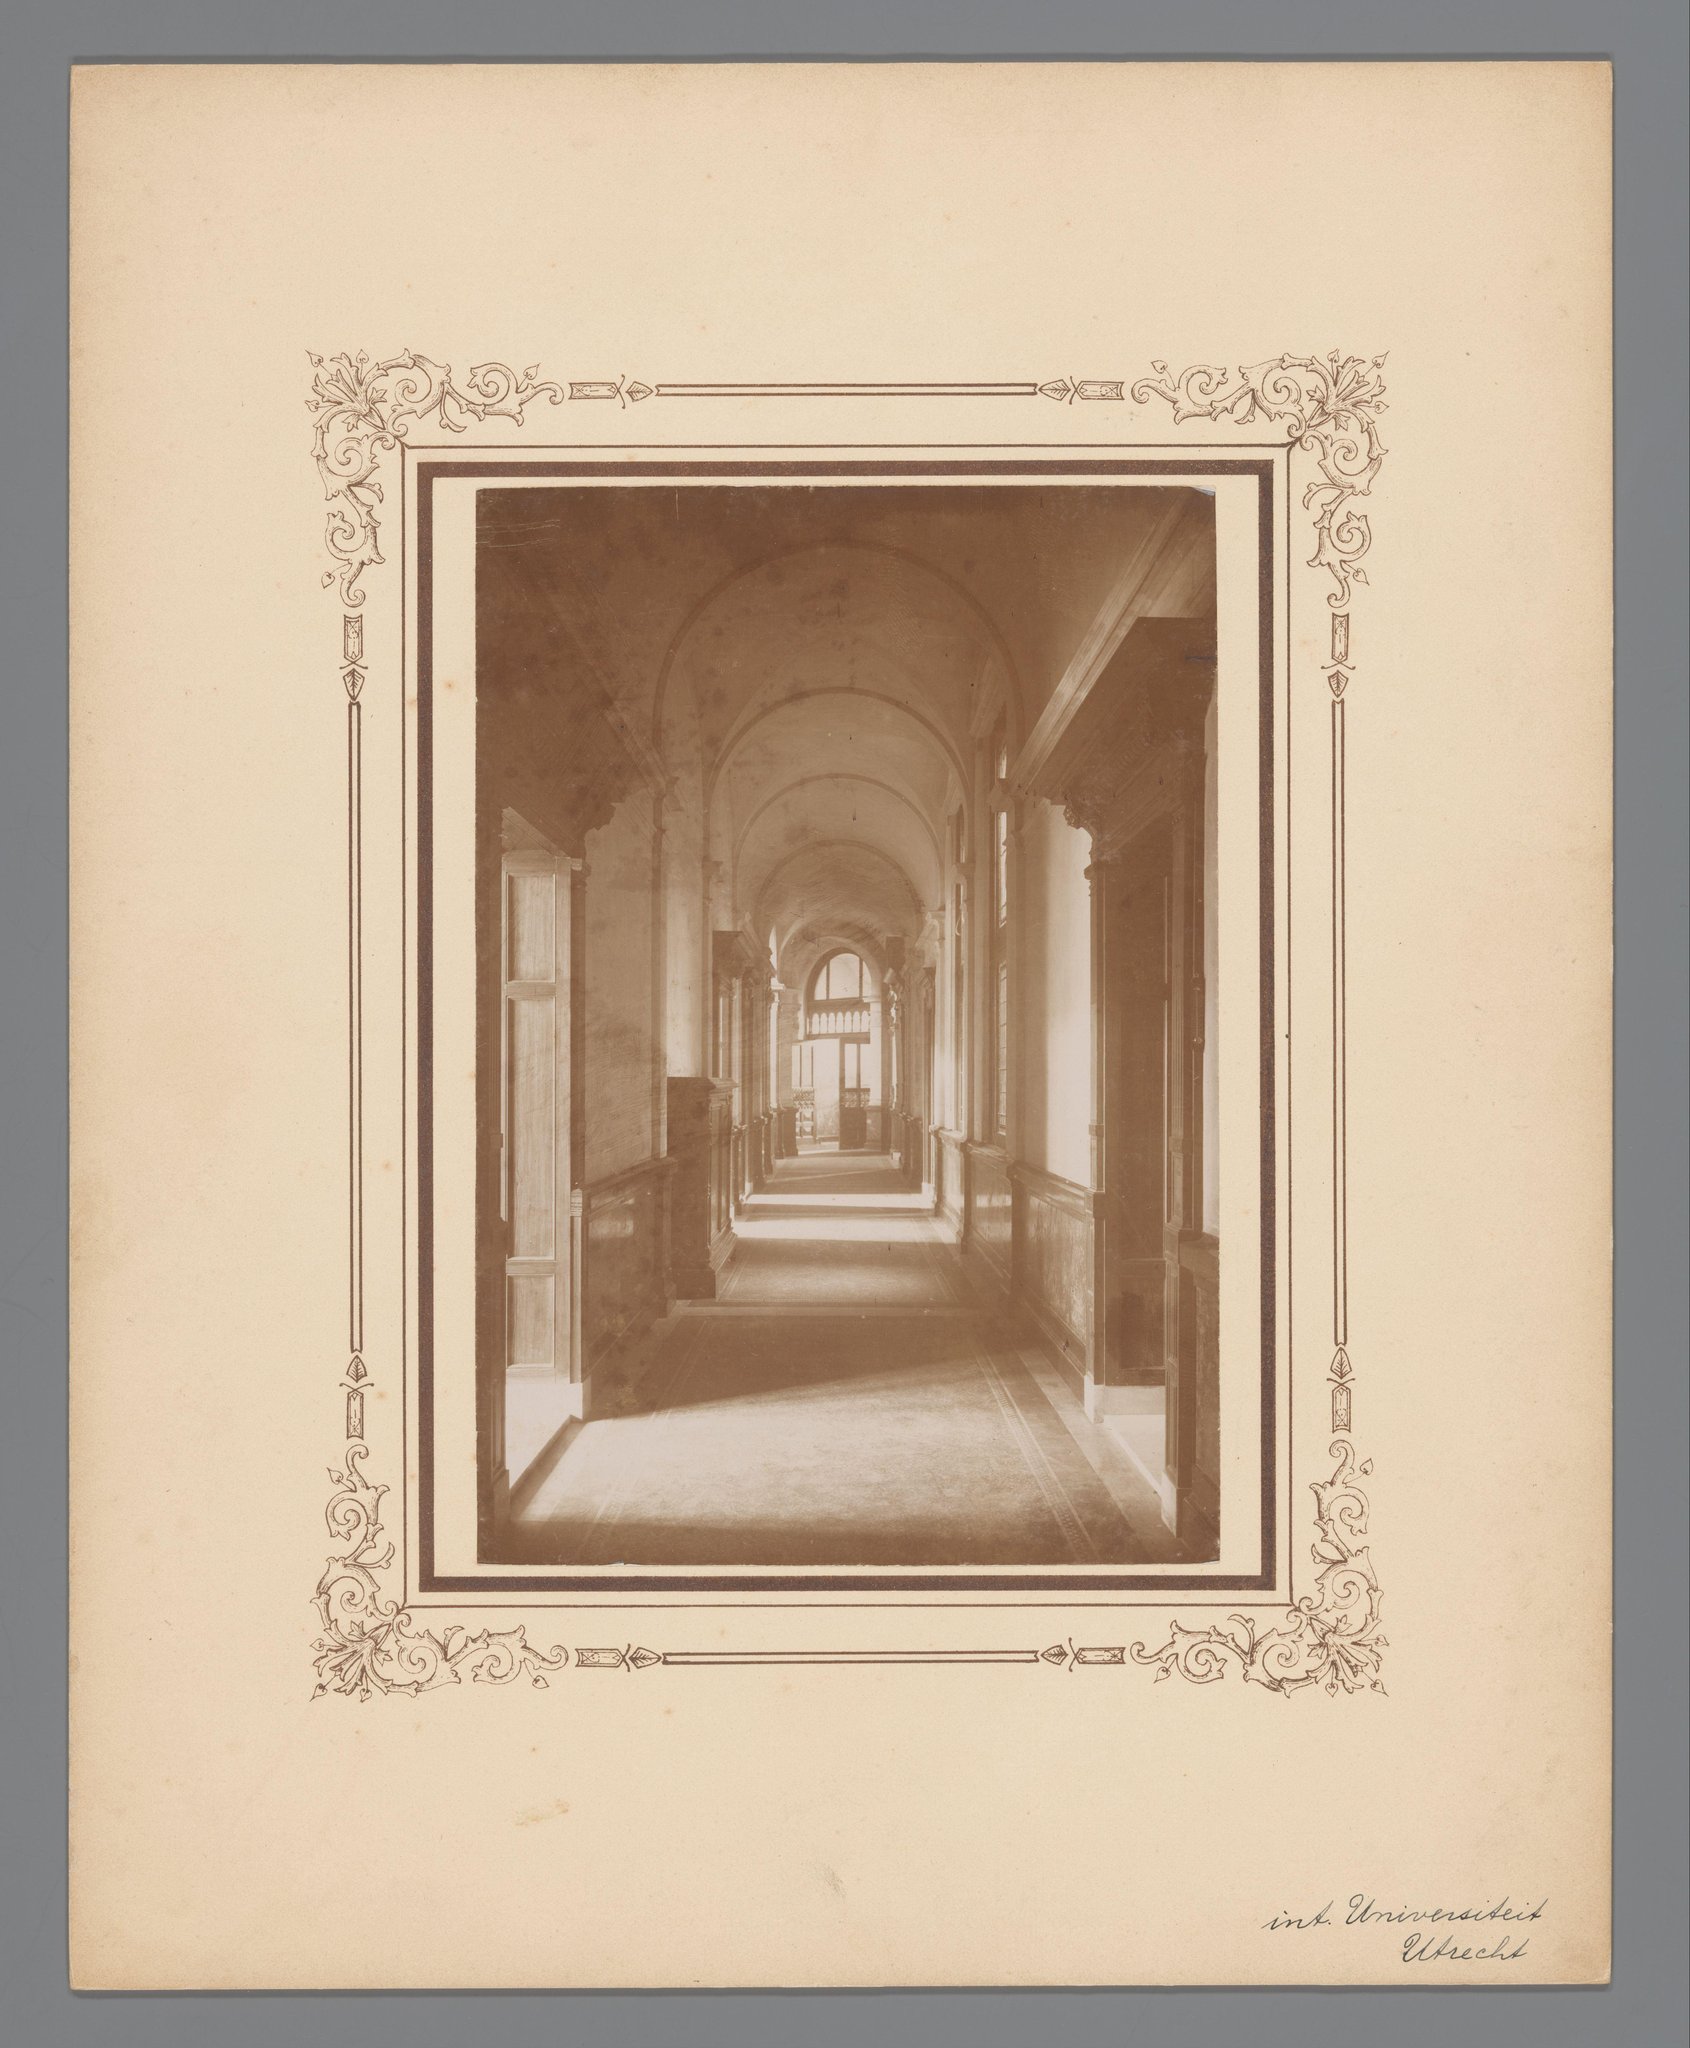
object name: photograph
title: Gang, vermoedelijk in het academiegebouw van de Universiteit van Utrecht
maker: Anonymous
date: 1890-1909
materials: cardboard, photographic support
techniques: collodion silver print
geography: utrecht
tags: gallery (spacious corridor)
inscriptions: number: ‘09' 78’, retailer's mark: ‘G. Hilhorst A zn/ Acad boek en kunsthandel/ Algem. Muziekh./ Domsteeg F.1/ Utrecht’, annotation: ‘int. Universiteit/ Utrecht’, collector's mark: Lugt 2228, annotation: ‘Nieuw (gang) Academie/ f0,45’